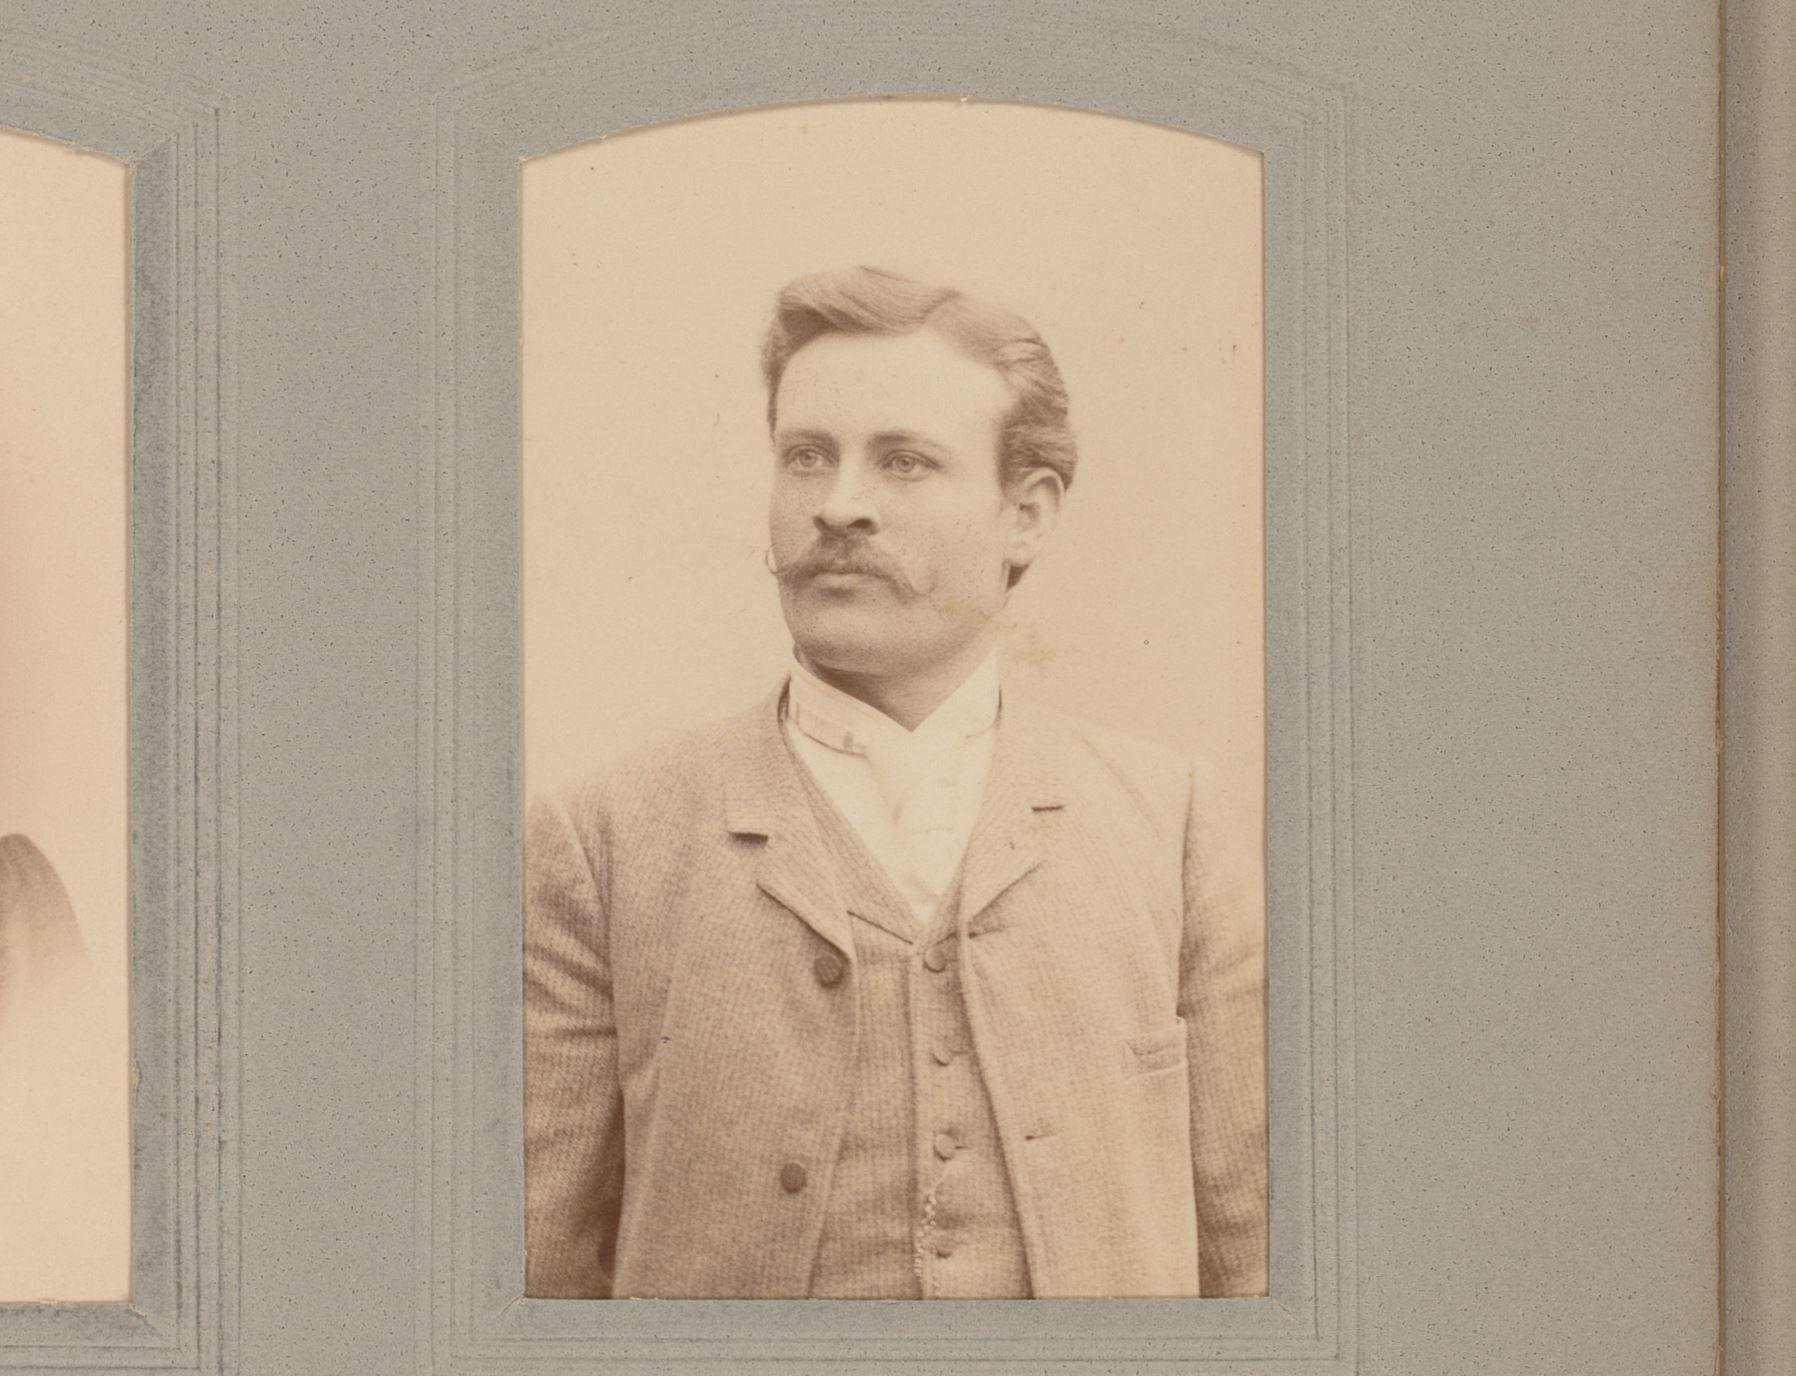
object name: carte de visite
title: Portret van een man met snor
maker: daniel nyblin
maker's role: fotograaf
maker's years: 1856-1923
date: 1860-1900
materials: cardboard, photographic support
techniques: albumen print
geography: helsinki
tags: moustache, historical persons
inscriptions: inscription: ‘D. Nyblin/ Helsingfors/ Helsinissä Fabianinkatu No 31./ (...)/ Plåten förvaras.’